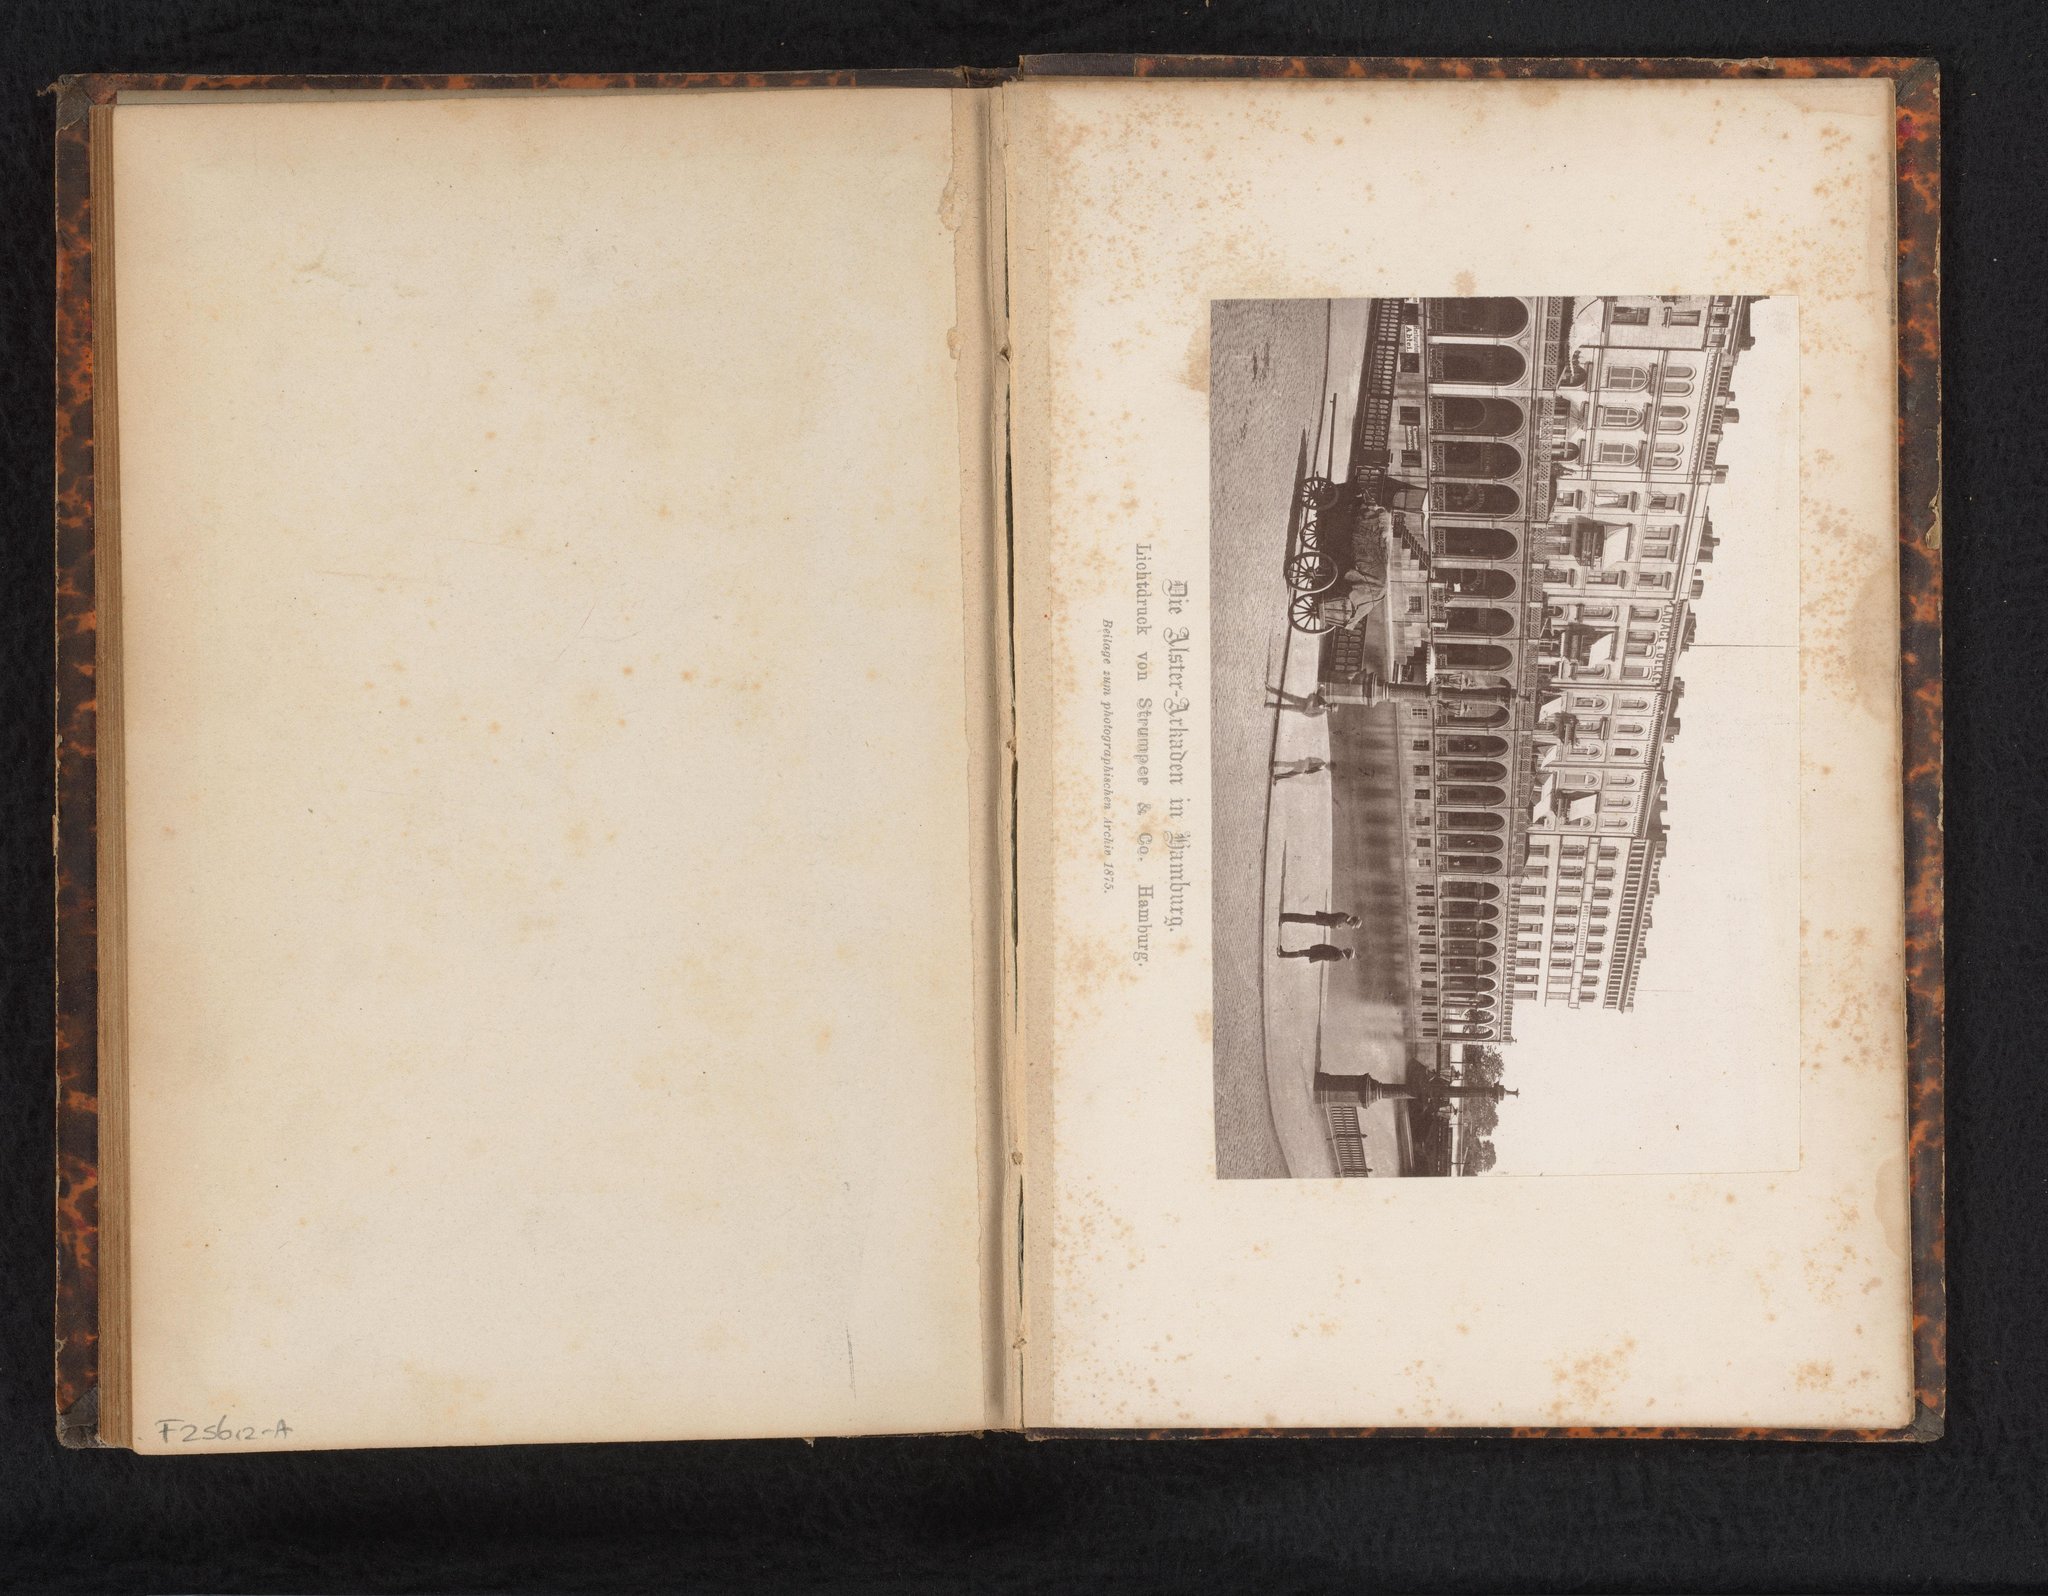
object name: page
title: Arcaden langs de Alster in Hamburg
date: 1870-1875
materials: cardboard, paper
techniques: photograph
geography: hamburg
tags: canals, waters (in city), arcade ~ architecture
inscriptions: inscription: ‘Beilage zum photographischen Archiv 1875.’